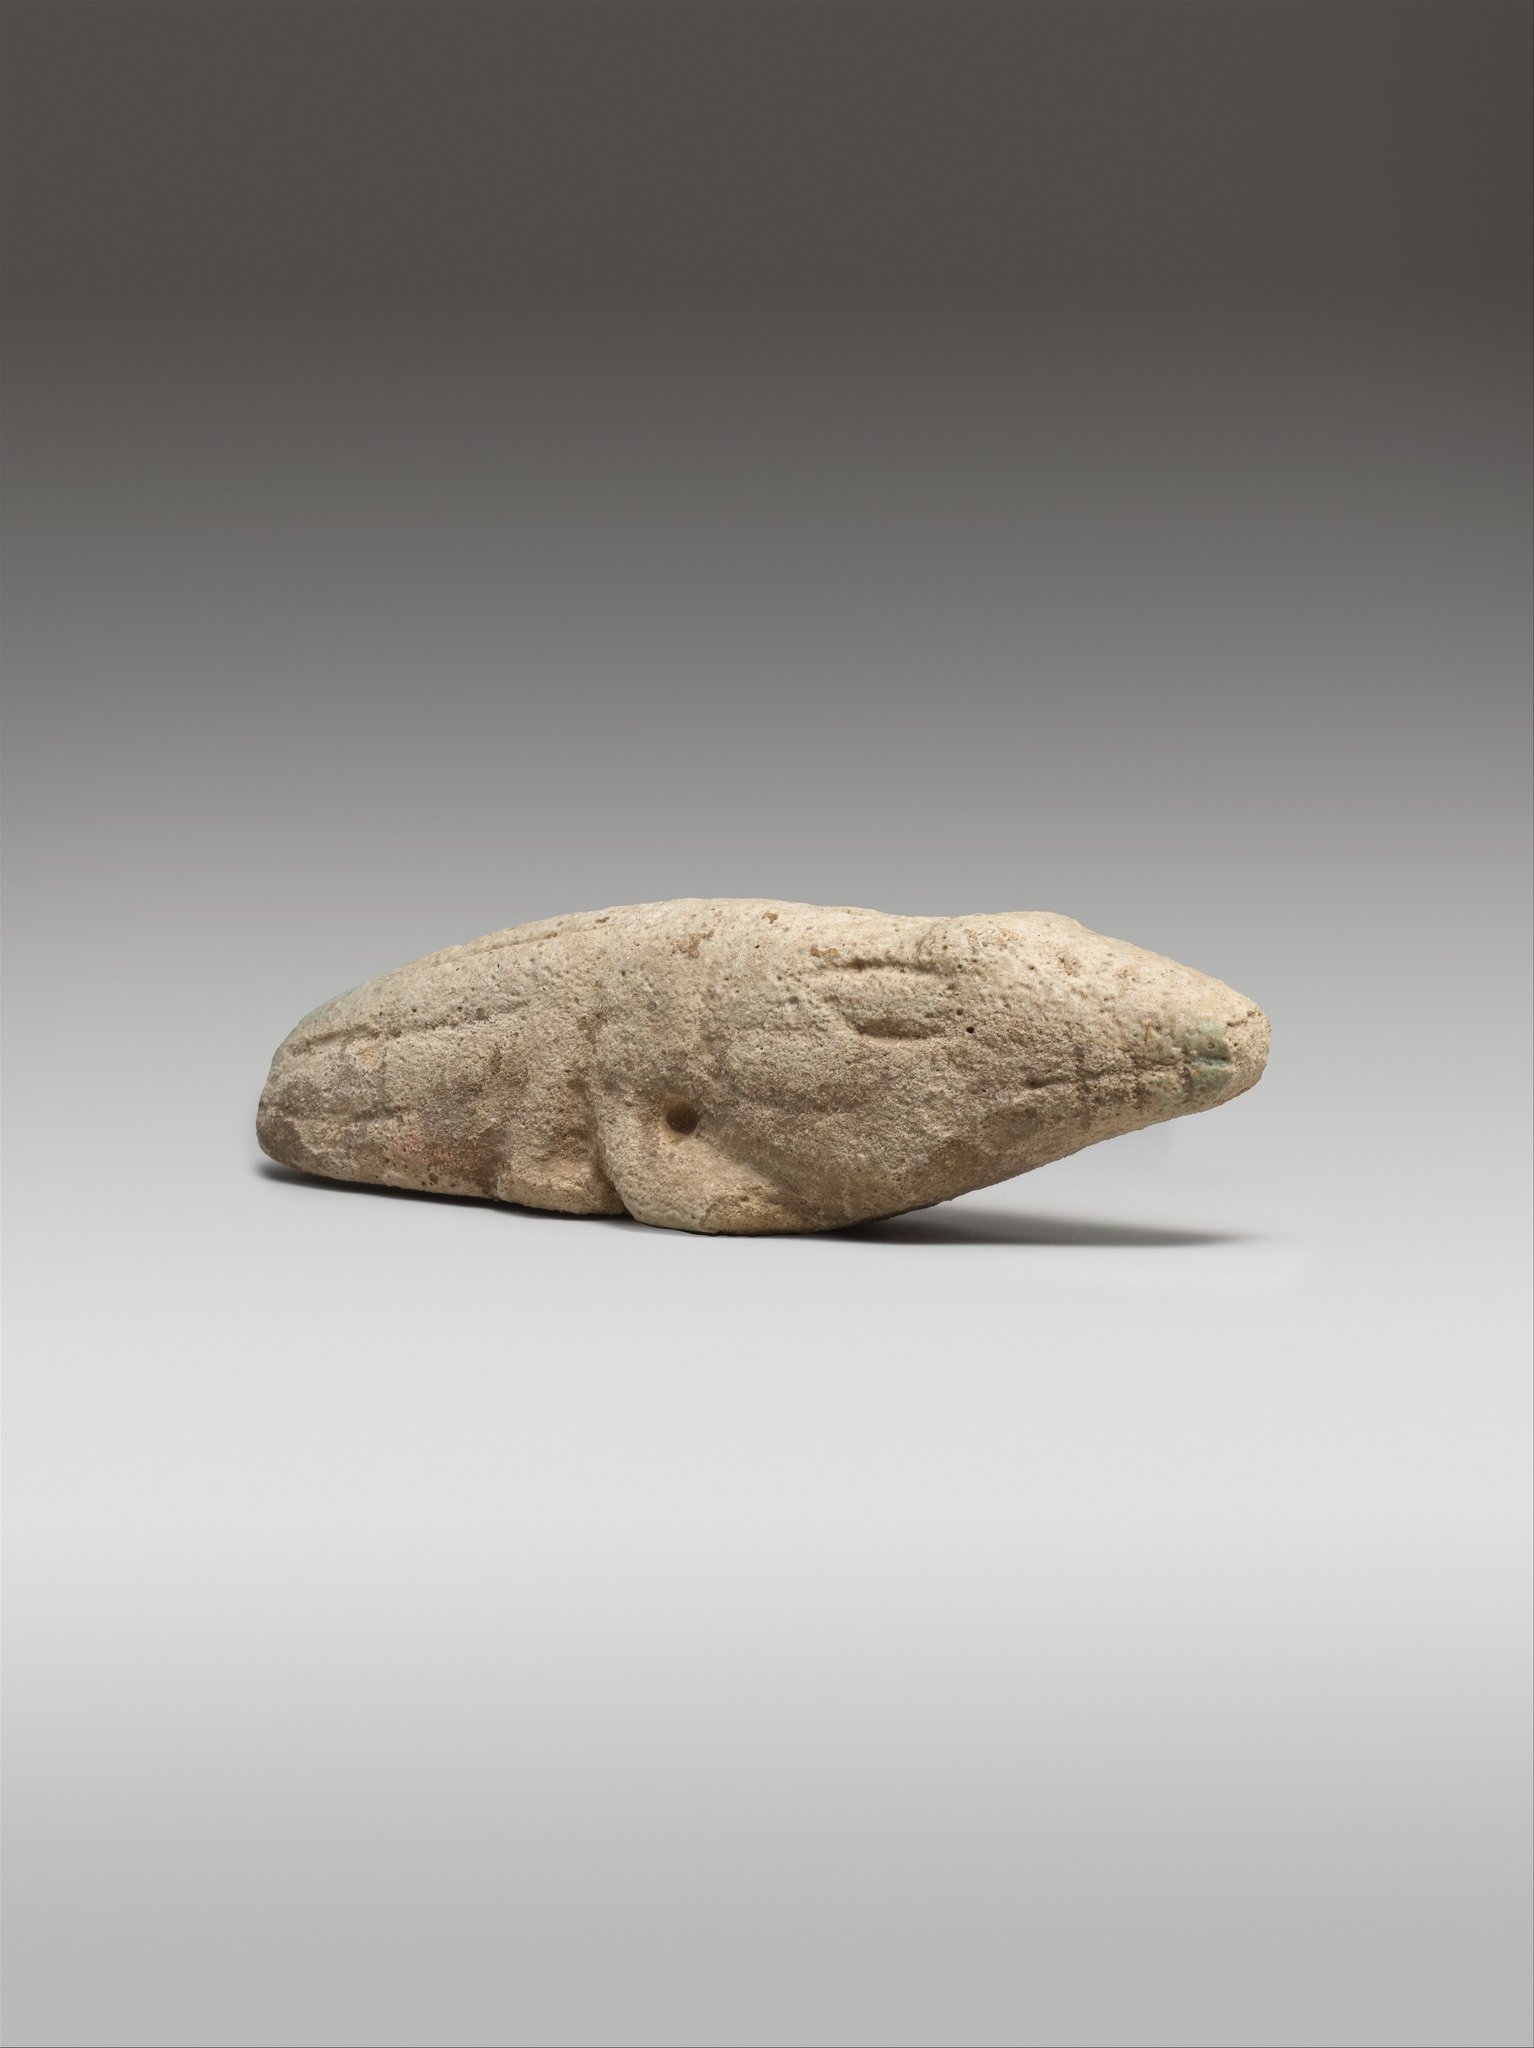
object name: amulet, crocodile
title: Crocodile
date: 3100-2649 BCE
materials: faience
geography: egypt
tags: crocodiles